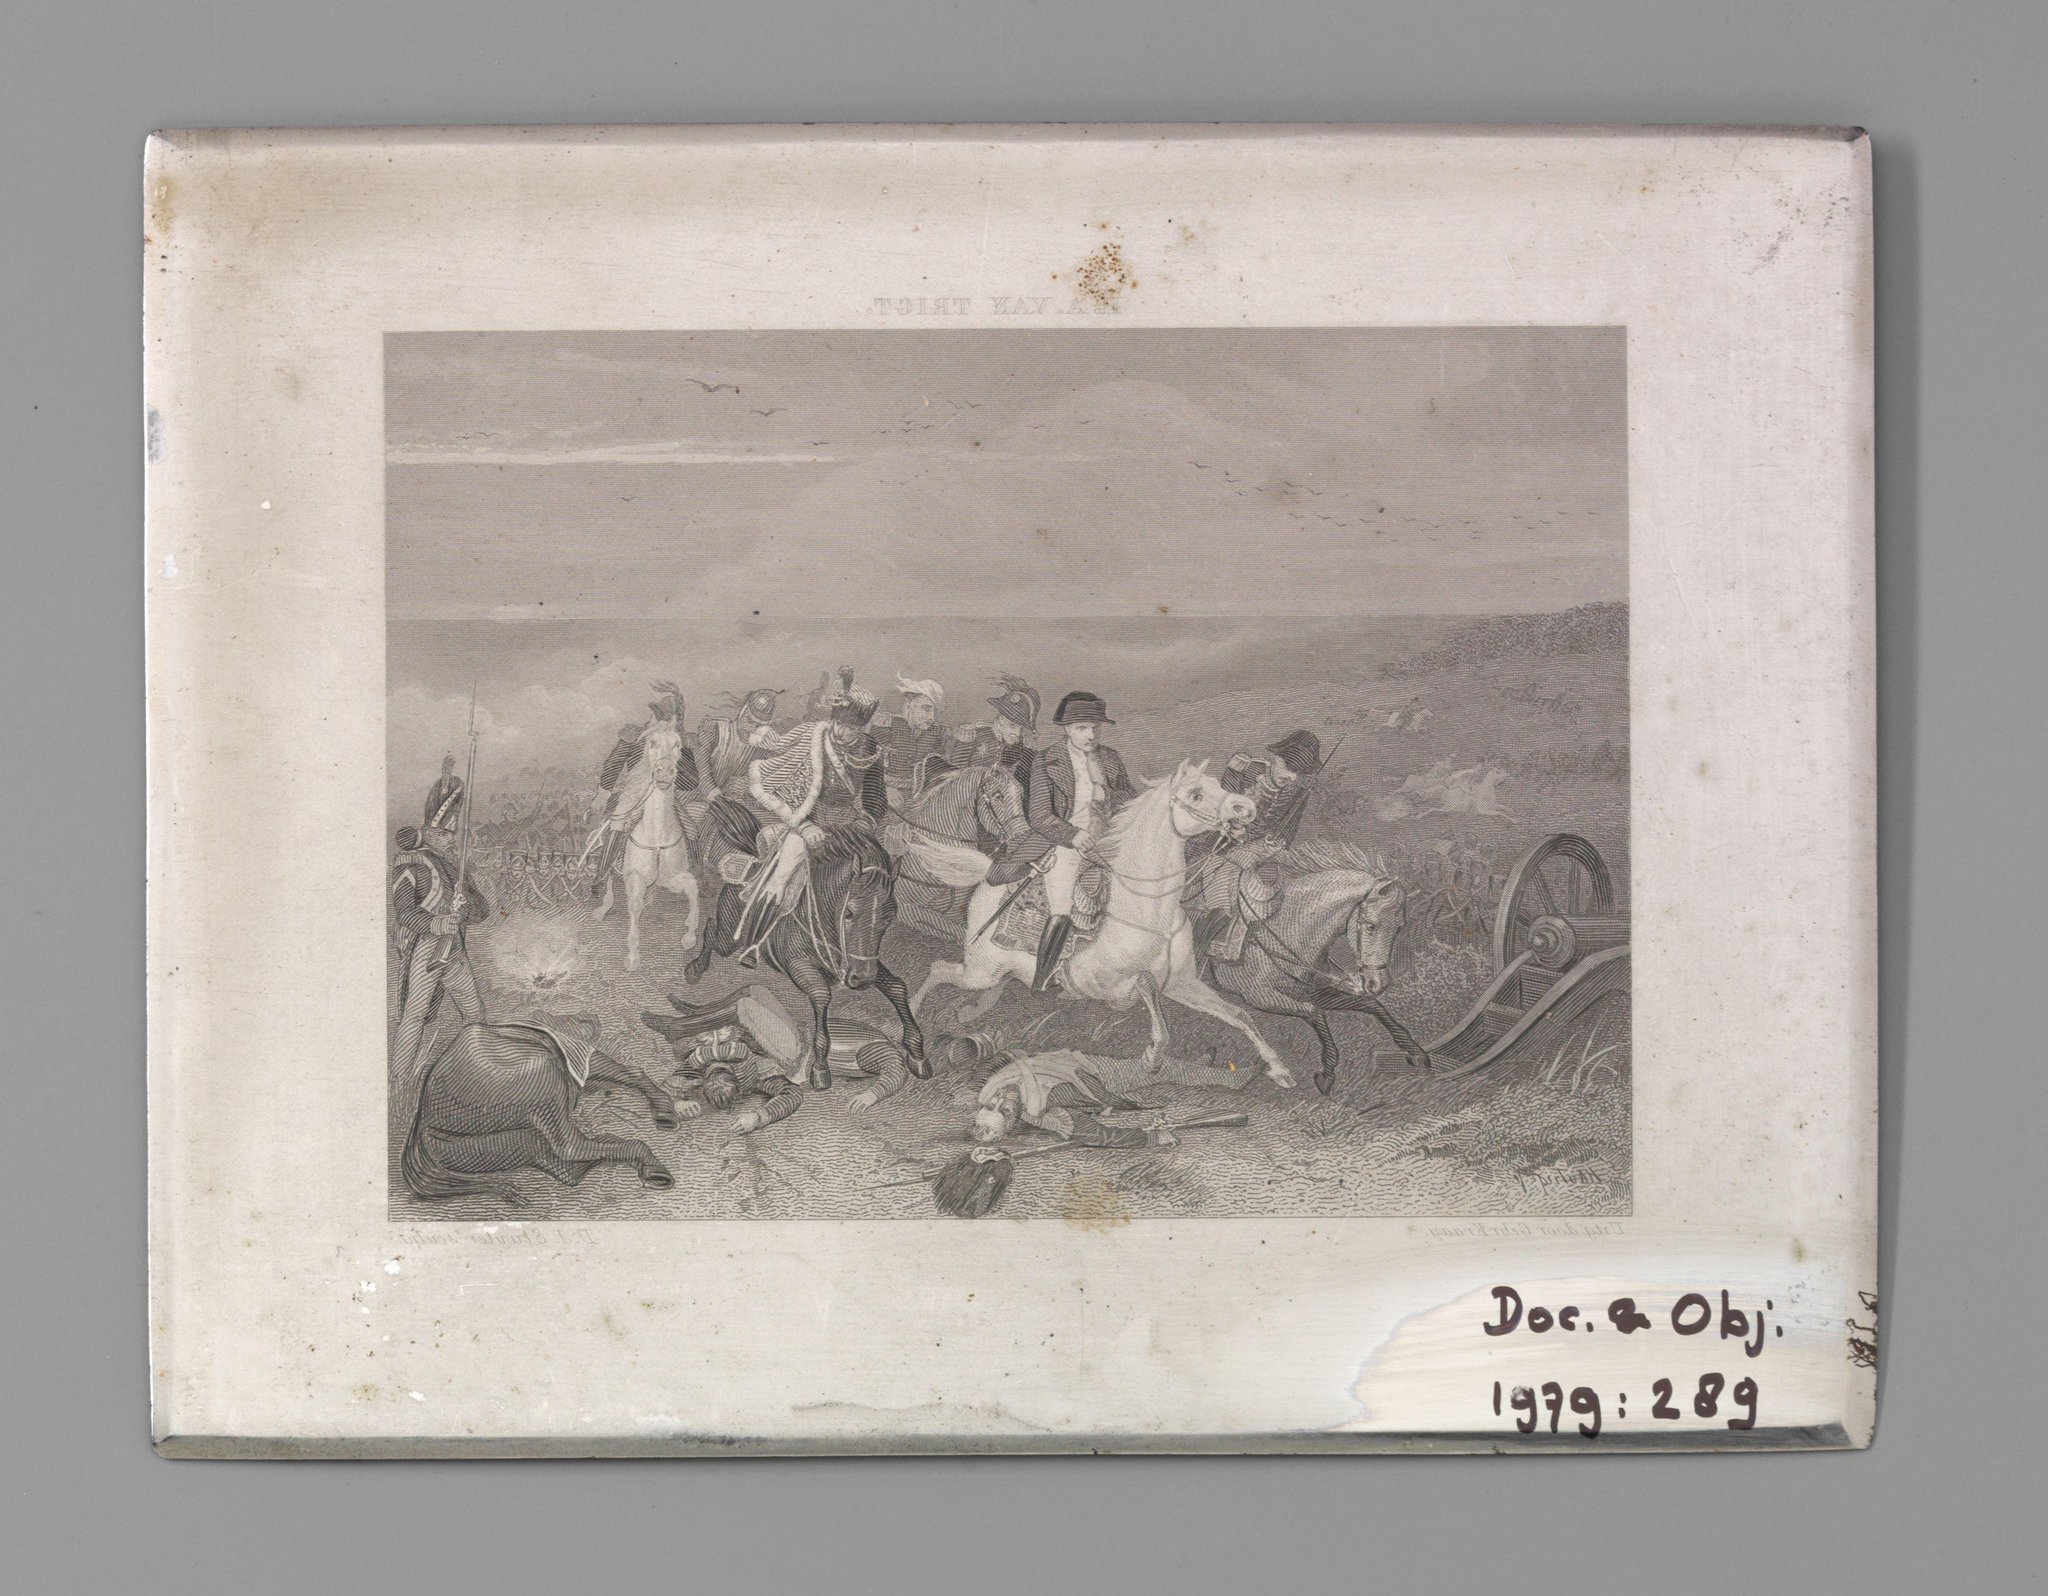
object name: staalplaat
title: Napoleon op het slagveld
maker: dirk jurriaan sluyter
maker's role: draughtsman, print maker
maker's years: 1811-1886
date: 1826-1886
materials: steel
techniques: engraving